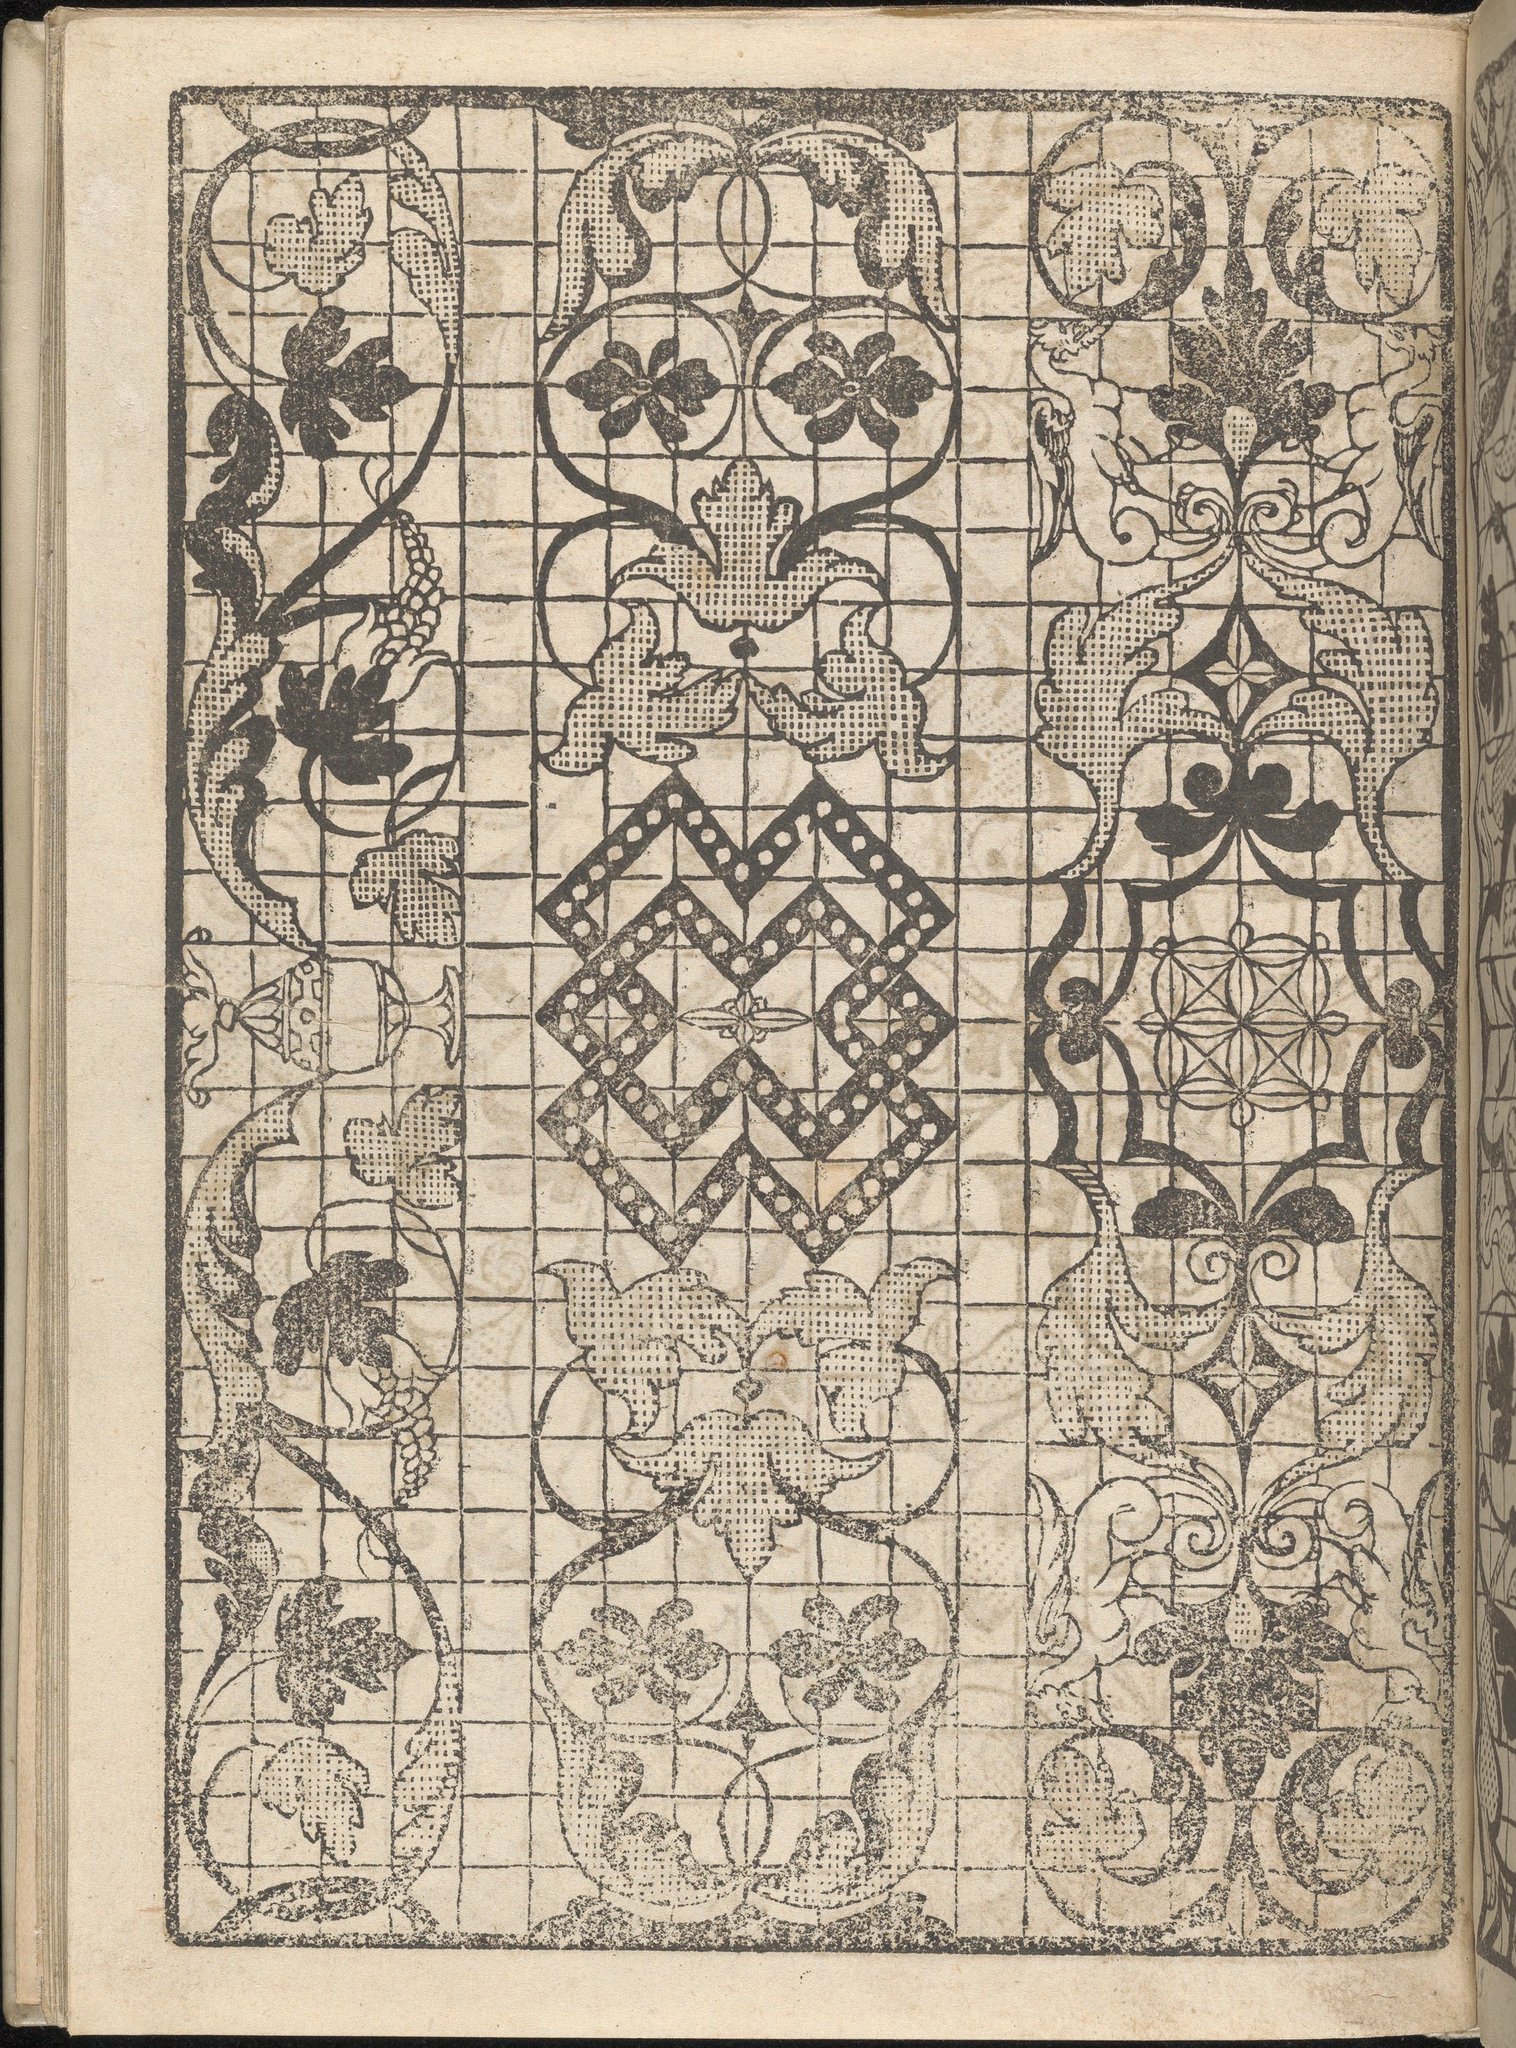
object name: book print ornament architecture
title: Splendore delle virtuose giovani, page 12 (verso)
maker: iseppo foresto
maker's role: designer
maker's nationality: italian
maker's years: 1520-1580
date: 1564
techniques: woodcut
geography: italy